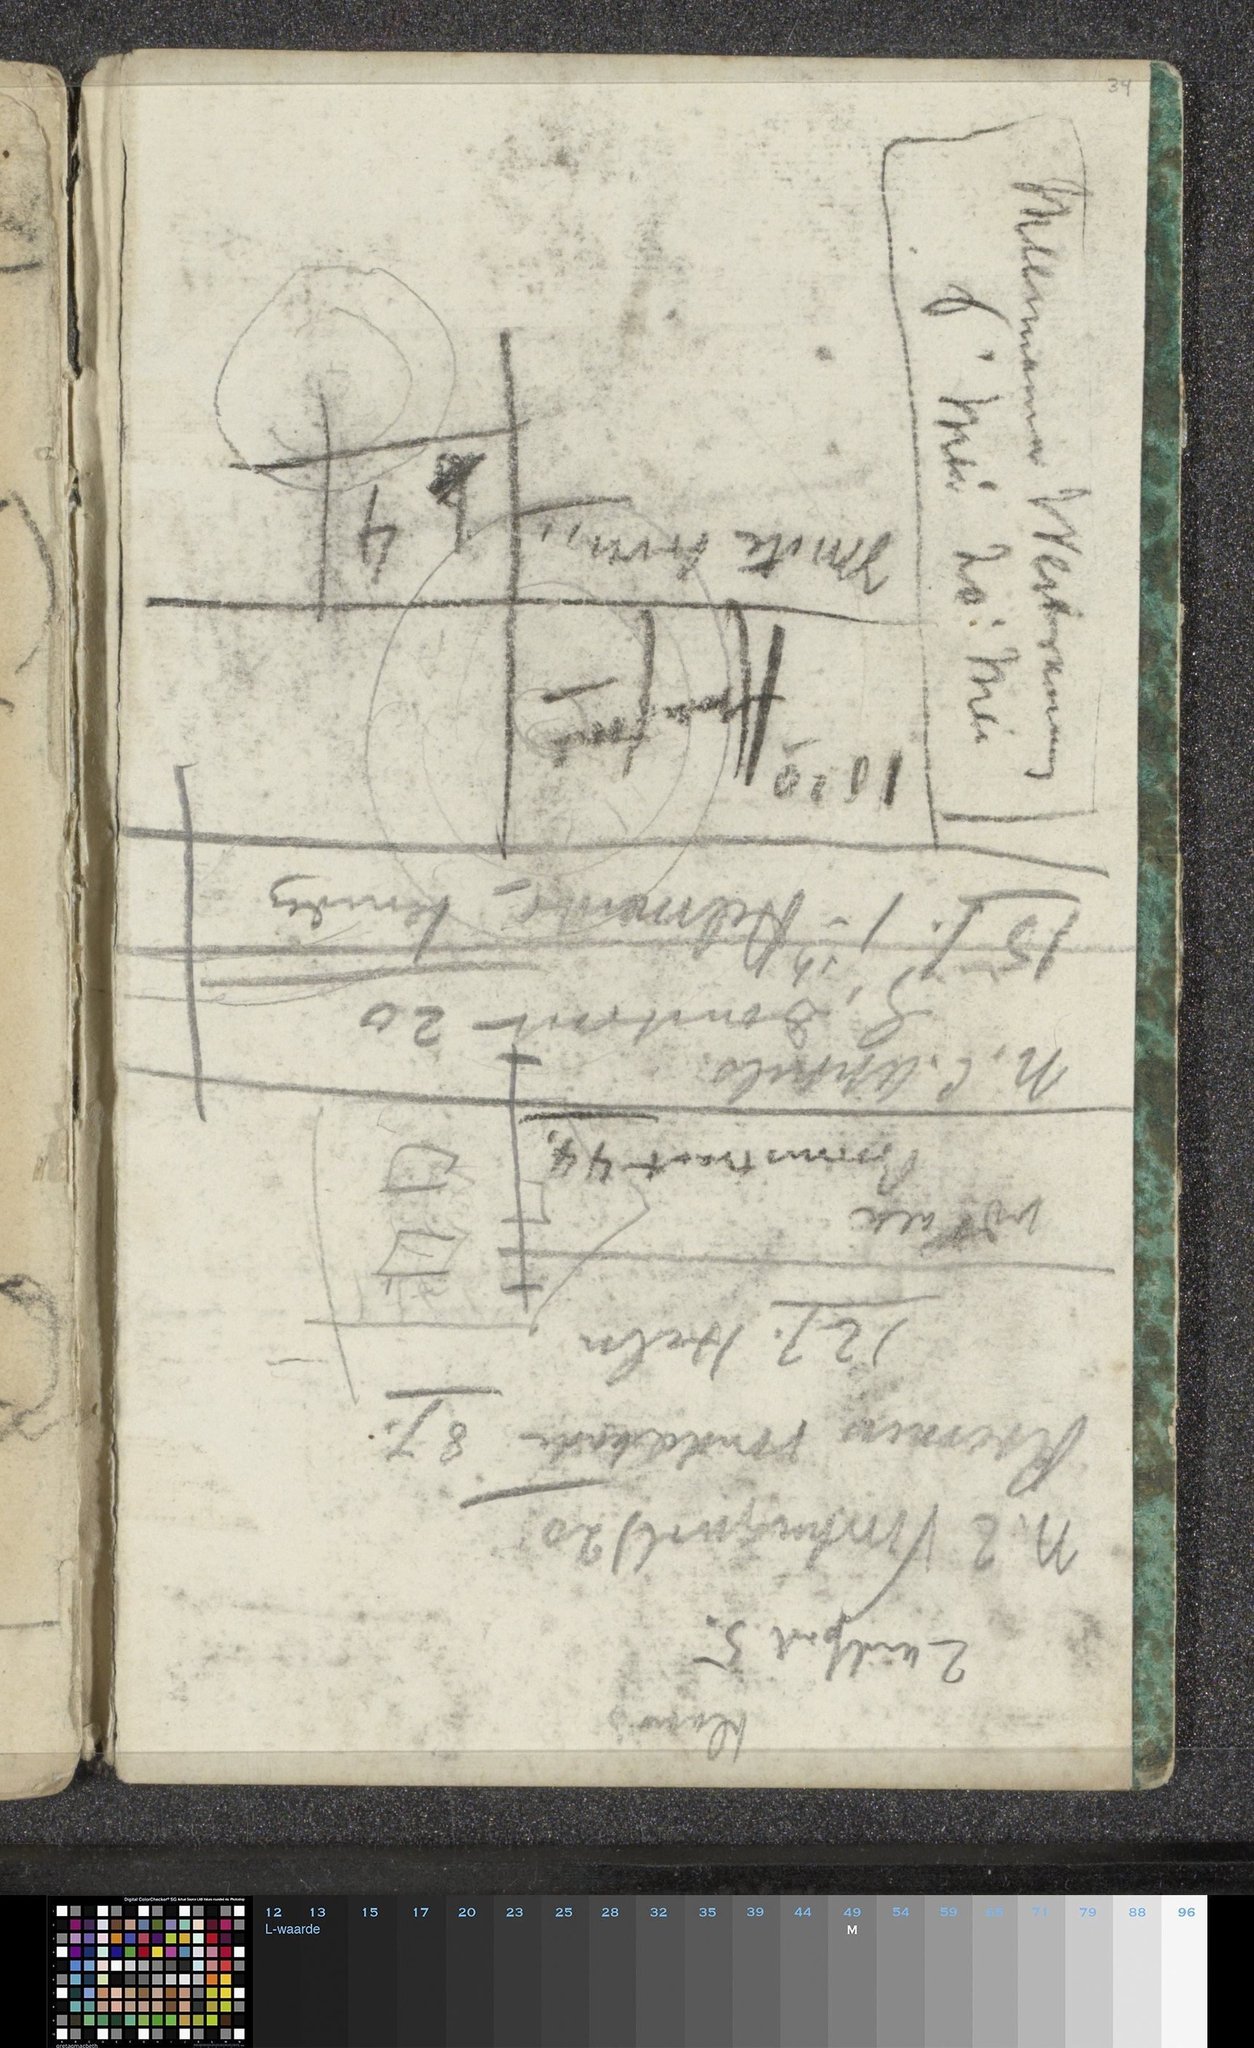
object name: sketchbook leaf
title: Studies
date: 1884-1886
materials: chalk, paper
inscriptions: annotation: ‘[...]/ N.Z. Voorburgwal 120/ Roemers Vondelkade 87/ [...]/ Vd Valk/ Boomstraat 44./ N.C. Appels/ G. Doustraat 20/ 157 1ste Helmerstraat beneden/ [...] 6 mei 20 mei’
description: Pagina 34, achterste schutblad, uit een schetsboek met 16 bladen.